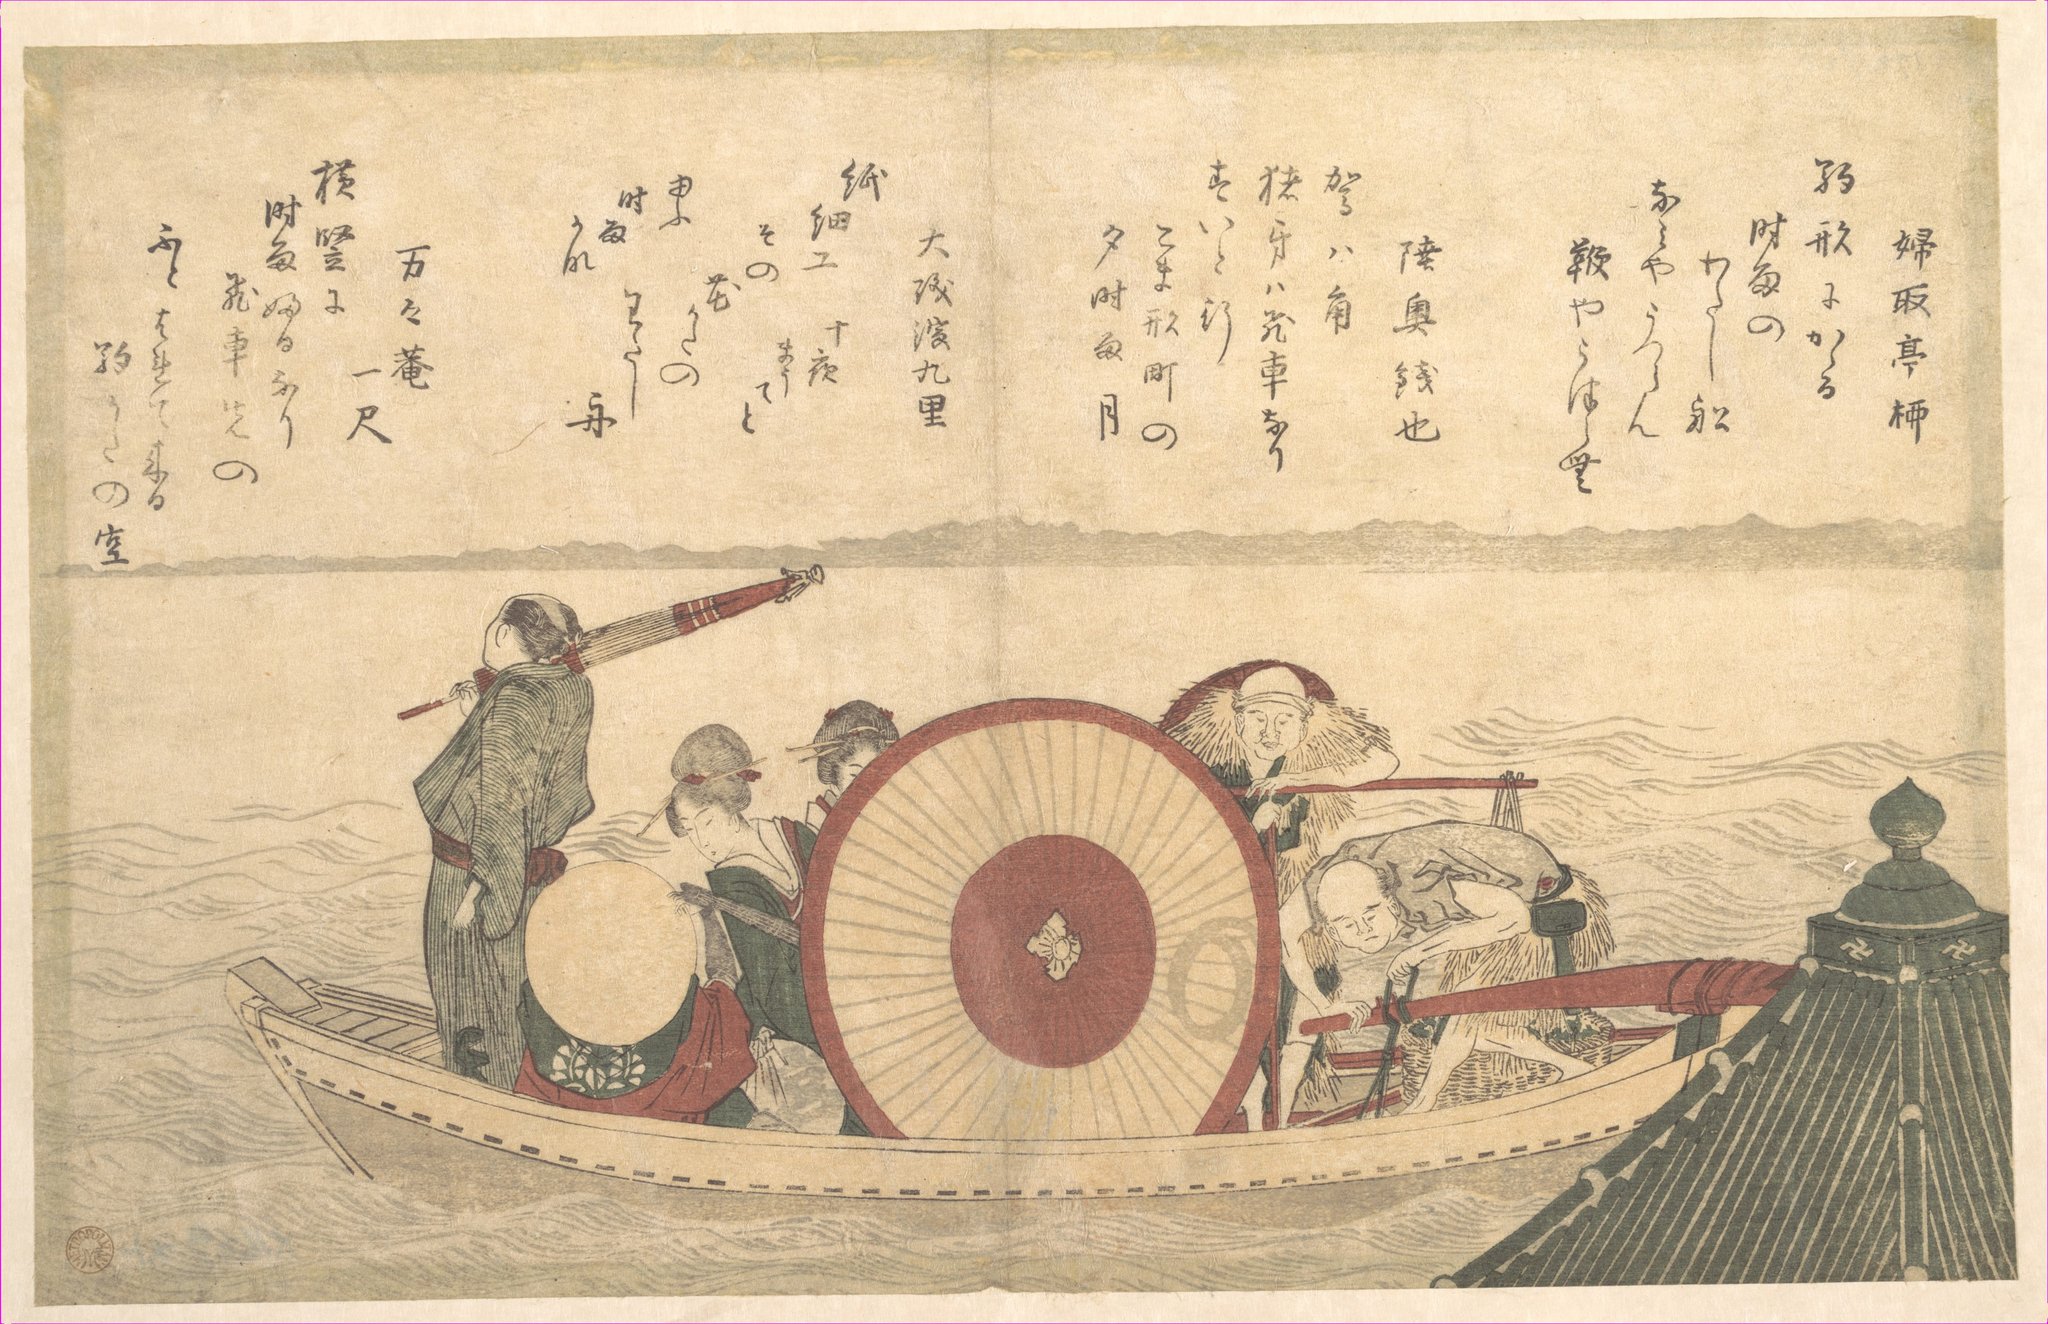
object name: print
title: A Ferry boat Crossing the Bay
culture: japanese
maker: katsushika hokusai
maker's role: artist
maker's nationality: japanese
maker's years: 1760-1849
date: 1760-1850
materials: ink, paper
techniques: surimono, woodblock print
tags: men,women,boats